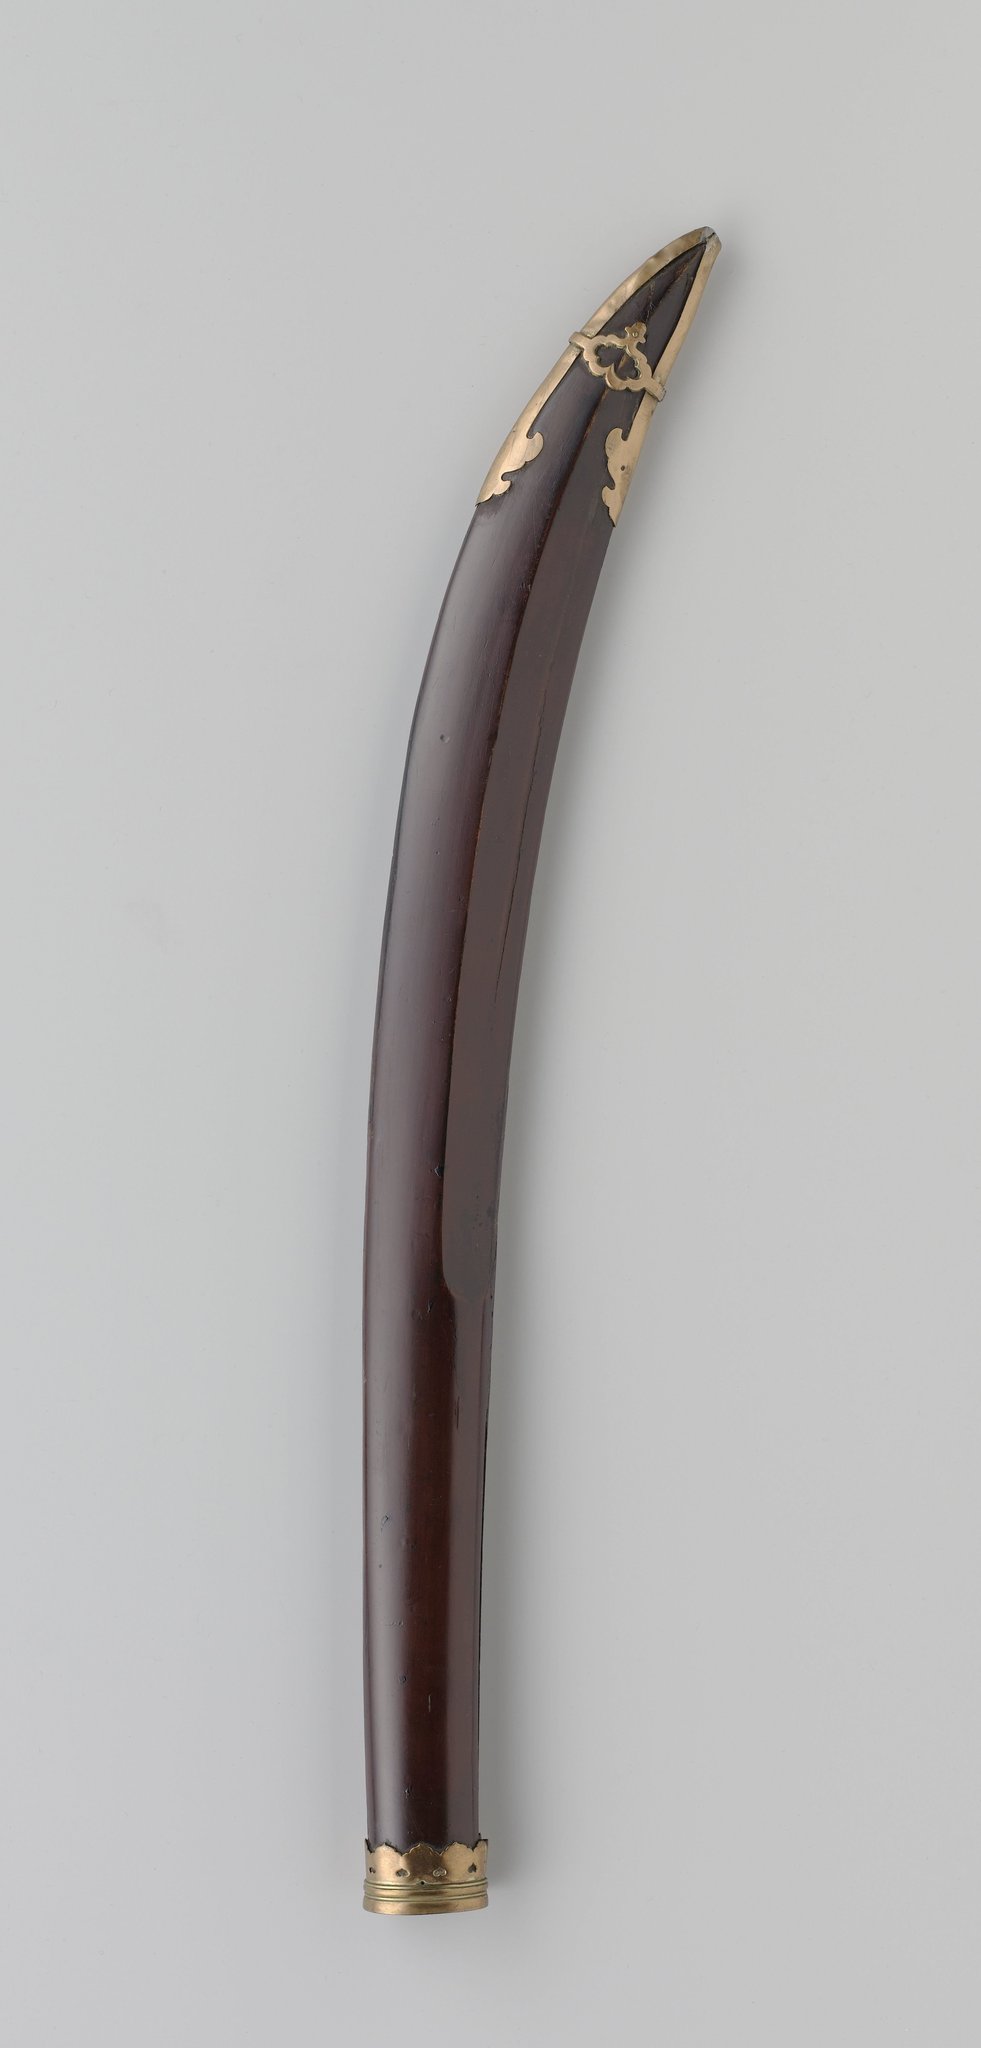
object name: knife with sheath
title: Schede van lans van Cornelis Tromp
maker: Anonymous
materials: brass, copper, wood, lacquer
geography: japan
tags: rotterdam, amsterdam, cornelis tromp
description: Arms rack. This arms rack of katsura wood stood in the Amsterdam home of Cornelis Tromp (1629-1691). It may have been given by the VOC. In the 17th century this was known as the East-Indian gun case. It was probably made by Chinese craftsmen working on the northern coast of Java in the 17th or 18th century. The arms rack is decorated with birds and flowers. The swords and lances are Japanese in shape. The blades and some of the mounts were certainly made in Japan.